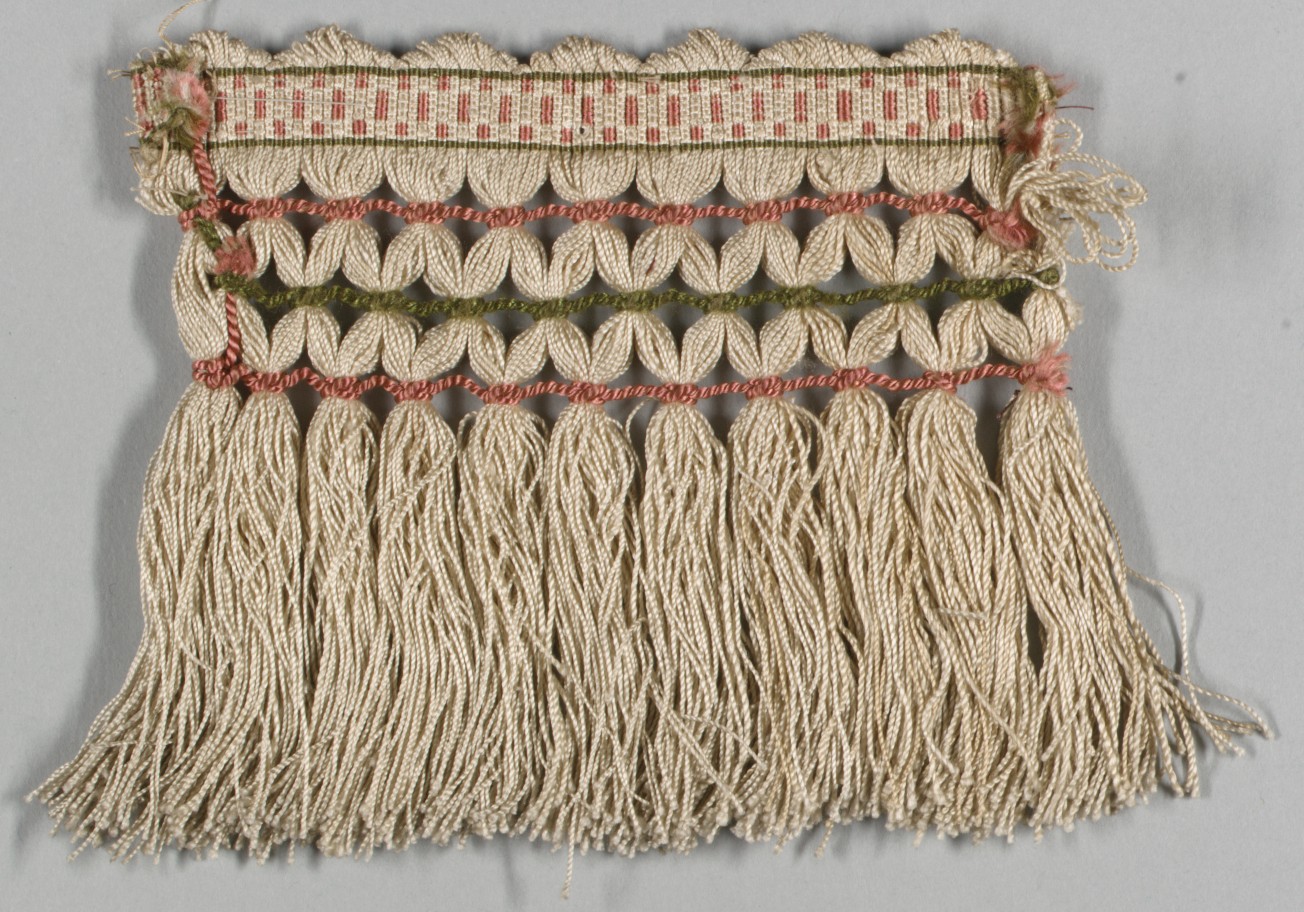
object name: fringe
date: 1801-1900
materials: silk